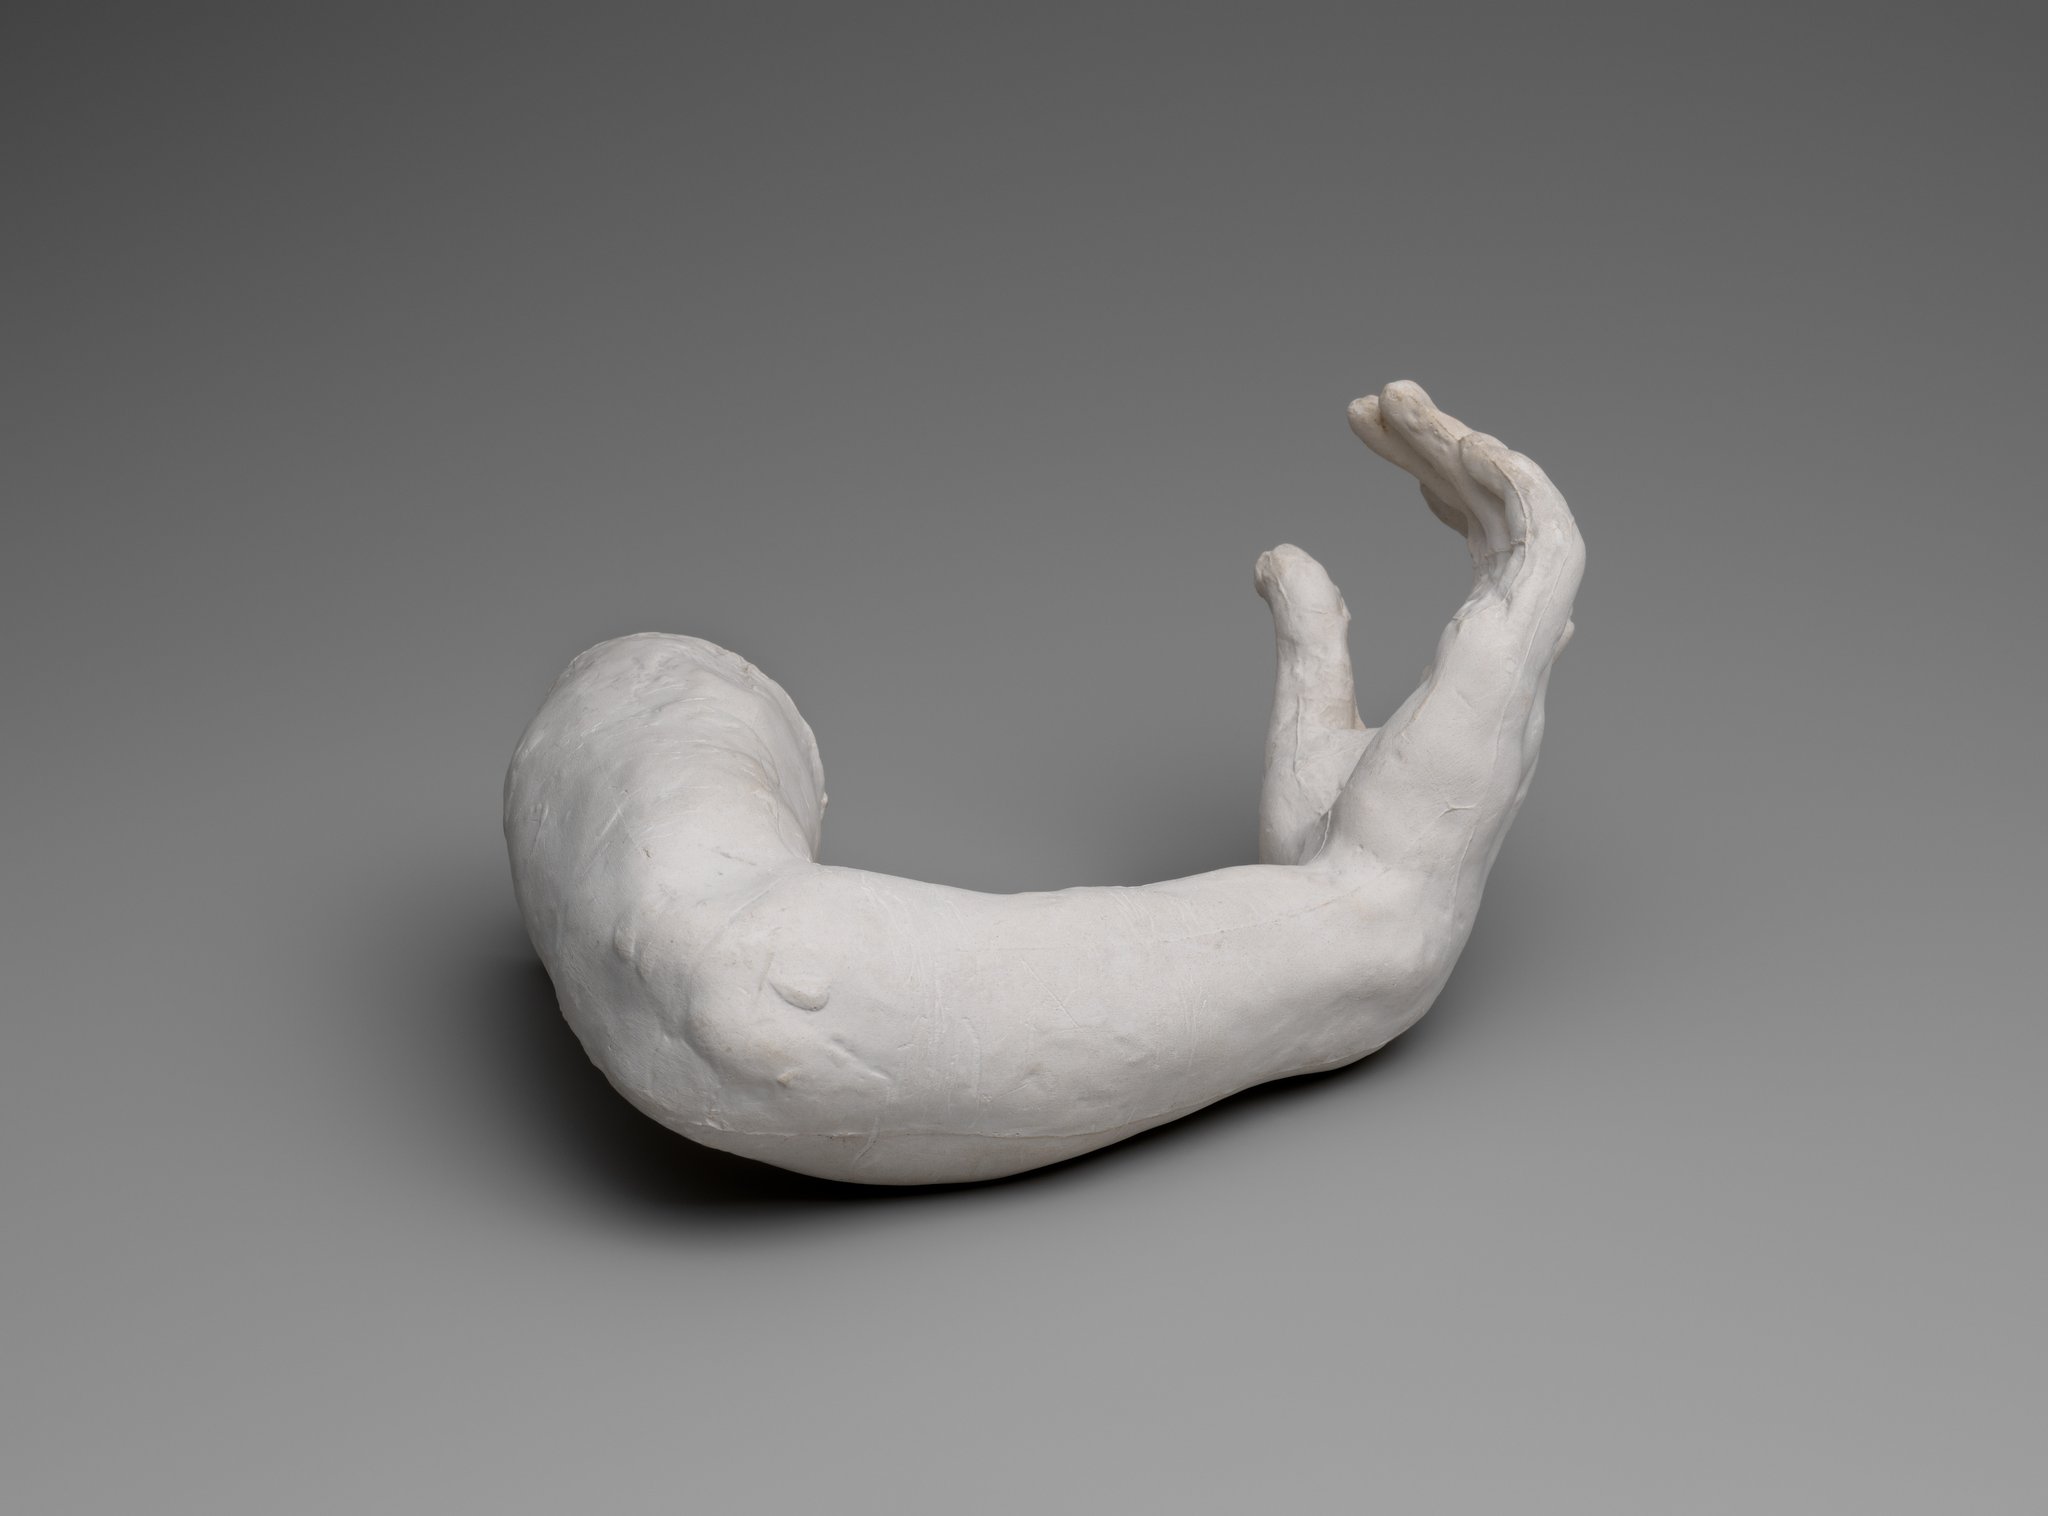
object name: cast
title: Study of the left hand and arm of Meditation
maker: auguste rodin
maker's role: artist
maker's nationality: french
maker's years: 1840-1917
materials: plaster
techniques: casting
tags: hands